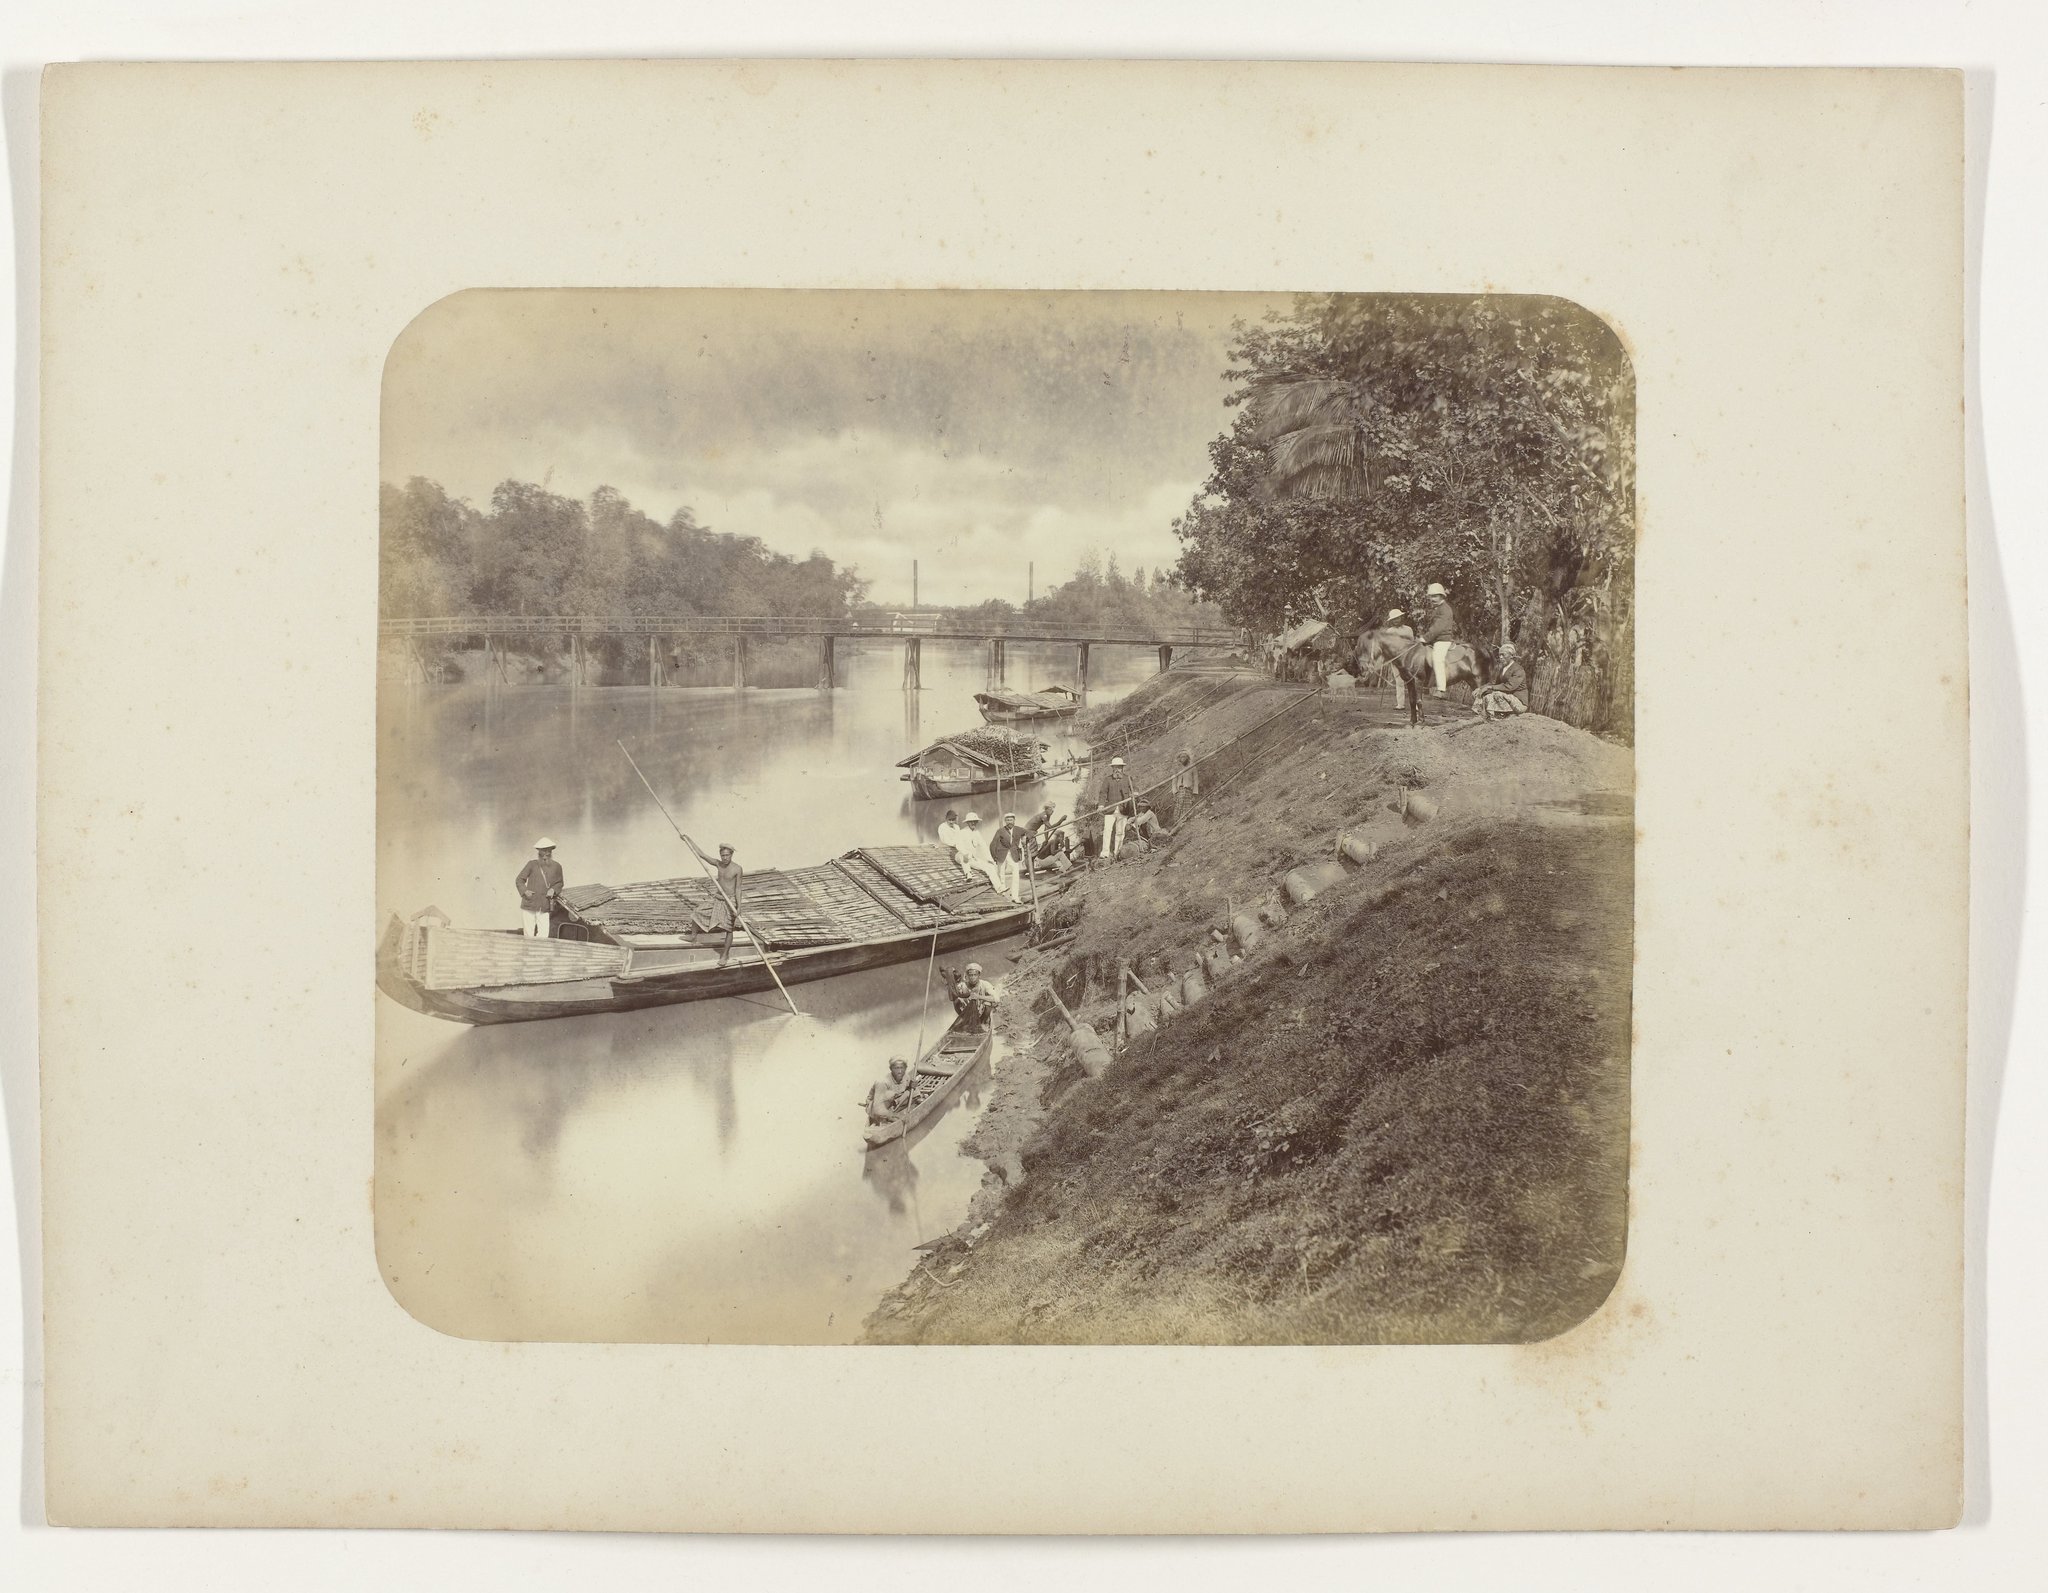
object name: photograph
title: De Kalibrantas bij Surabaya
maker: herman salzwedel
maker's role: fotograaf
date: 1876-1884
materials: photographic support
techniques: albumen print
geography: surabaya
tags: utrecht, the hague, colonial system, river, surabaya, java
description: De Kalibrantas bij Surabaya met centraal een grote prauw met een inlander met een lange vaarboom met voorop een Europeaan met baard en tropenhelm. Op de wal diverse inlanders en Europeanen. Op de rivier drie andere prauwen en op de achtergrond een houten brug. In de verte twee schoorsteenpijpen. Onderdeel van het fotoalbum door de Soerabayasche Vereeniging van Suikerfabrikanten aangeboden aan Frederik Beyerinck, resident van Soerabaja.